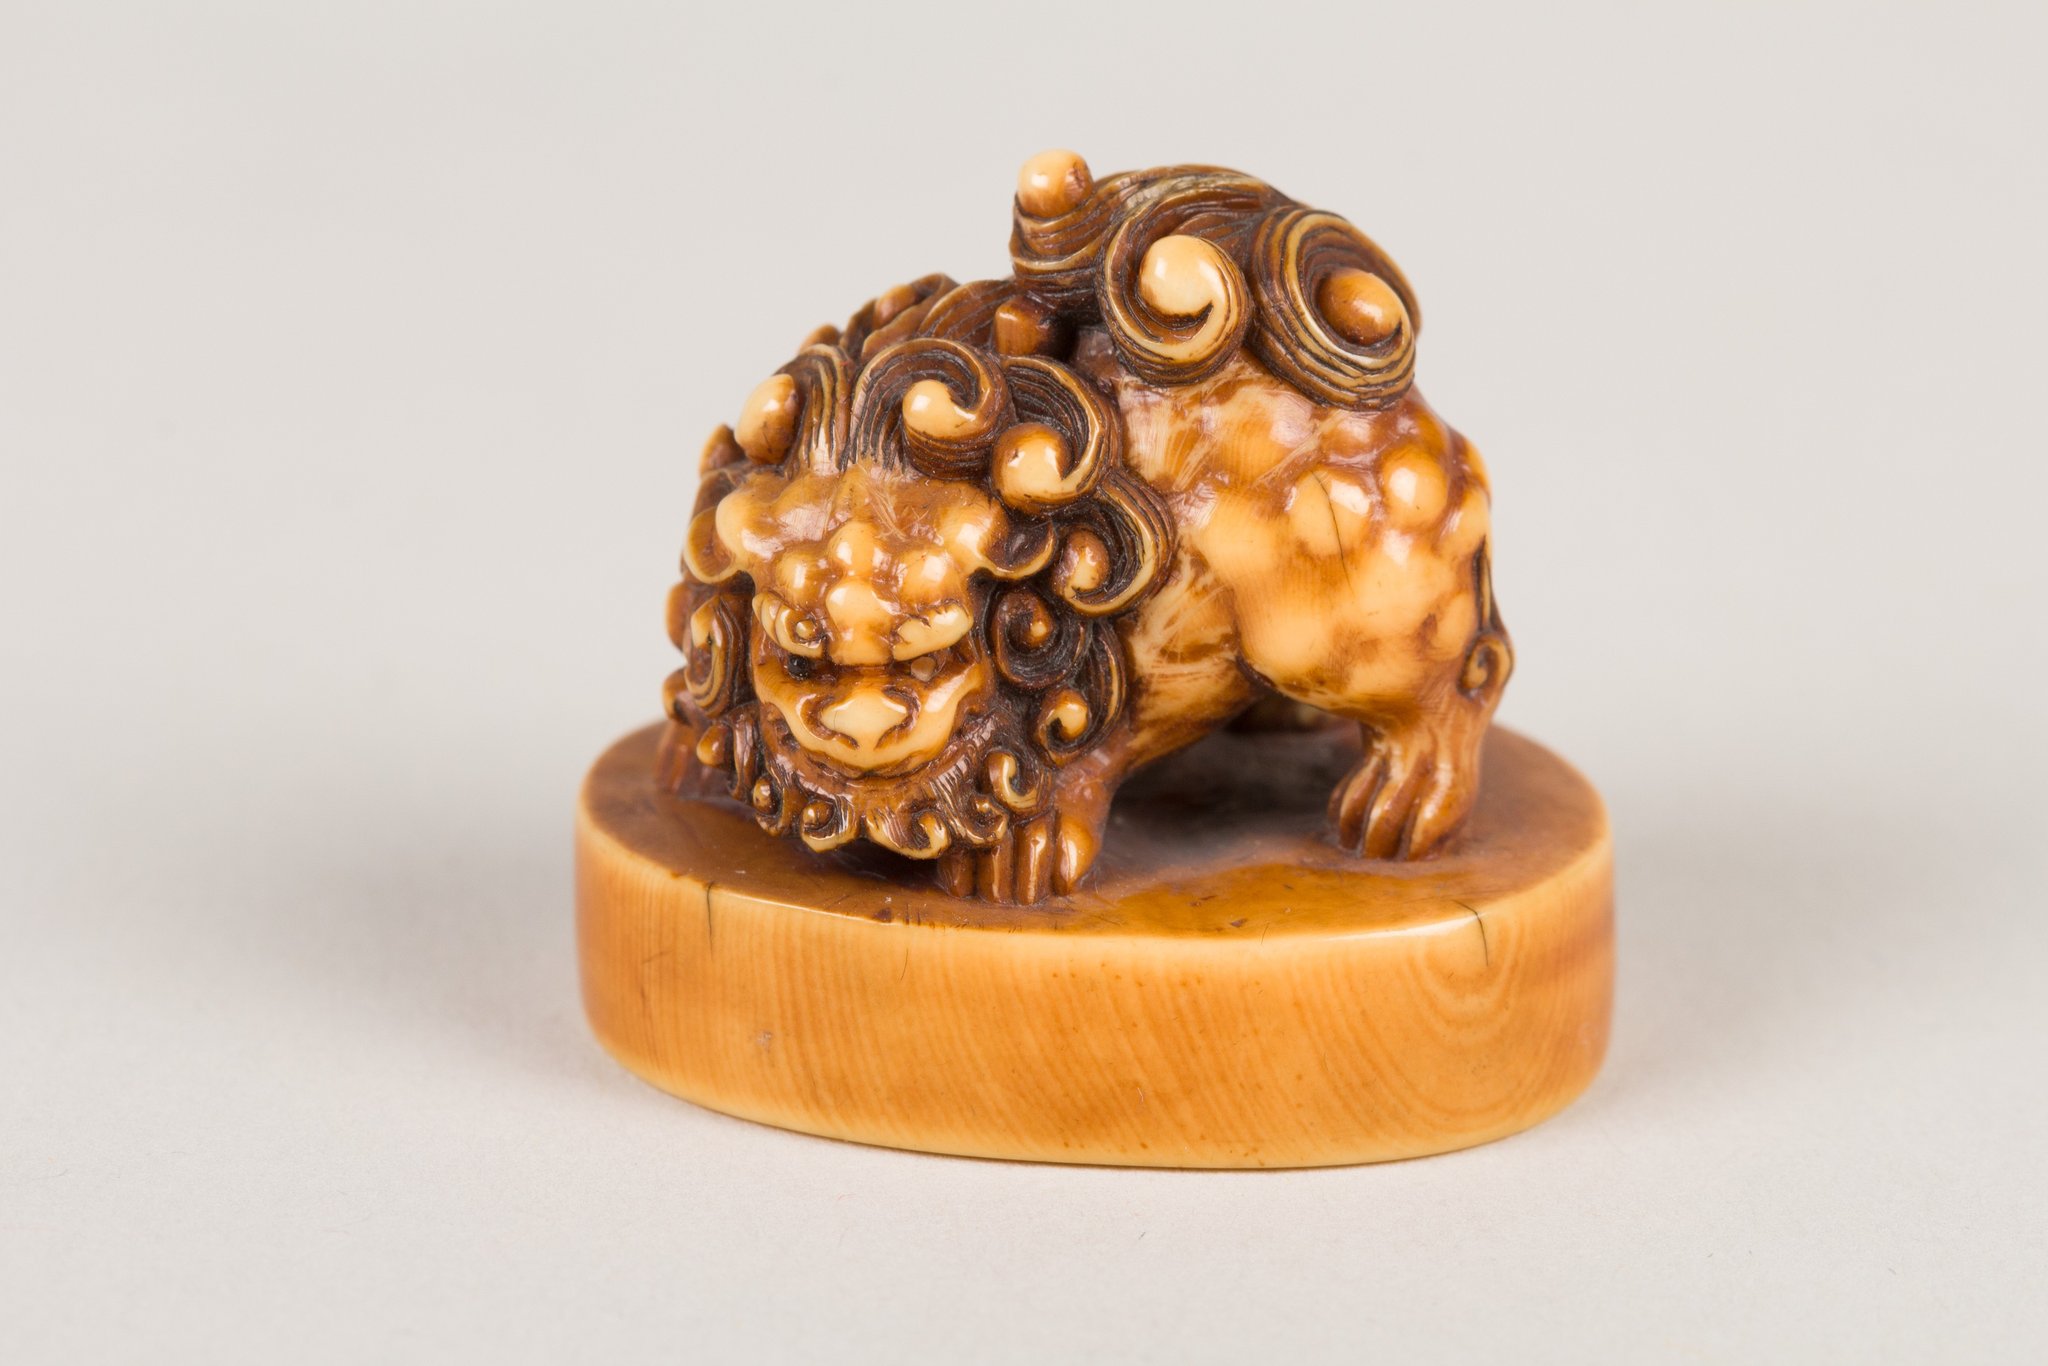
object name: netsuke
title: Netsuke of Qilin on a Pedestal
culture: japanese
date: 1801-1900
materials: ivory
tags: mythical creatures